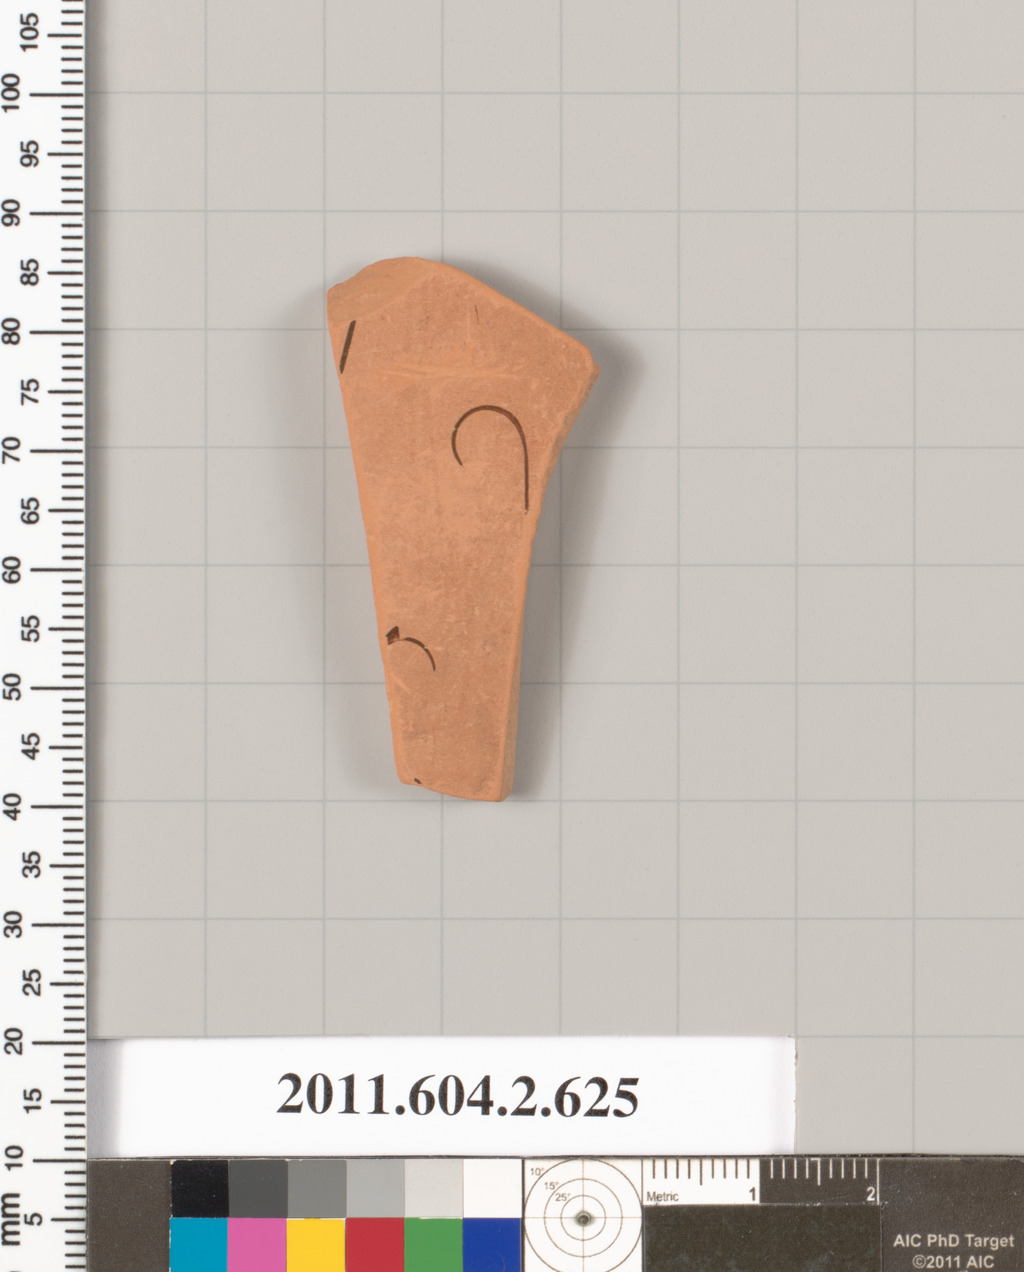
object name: column krater fragment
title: Terracotta fragment of a column-krater (bowl for mixing wine and water)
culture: greek, attic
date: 460-440 BCE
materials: terracotta